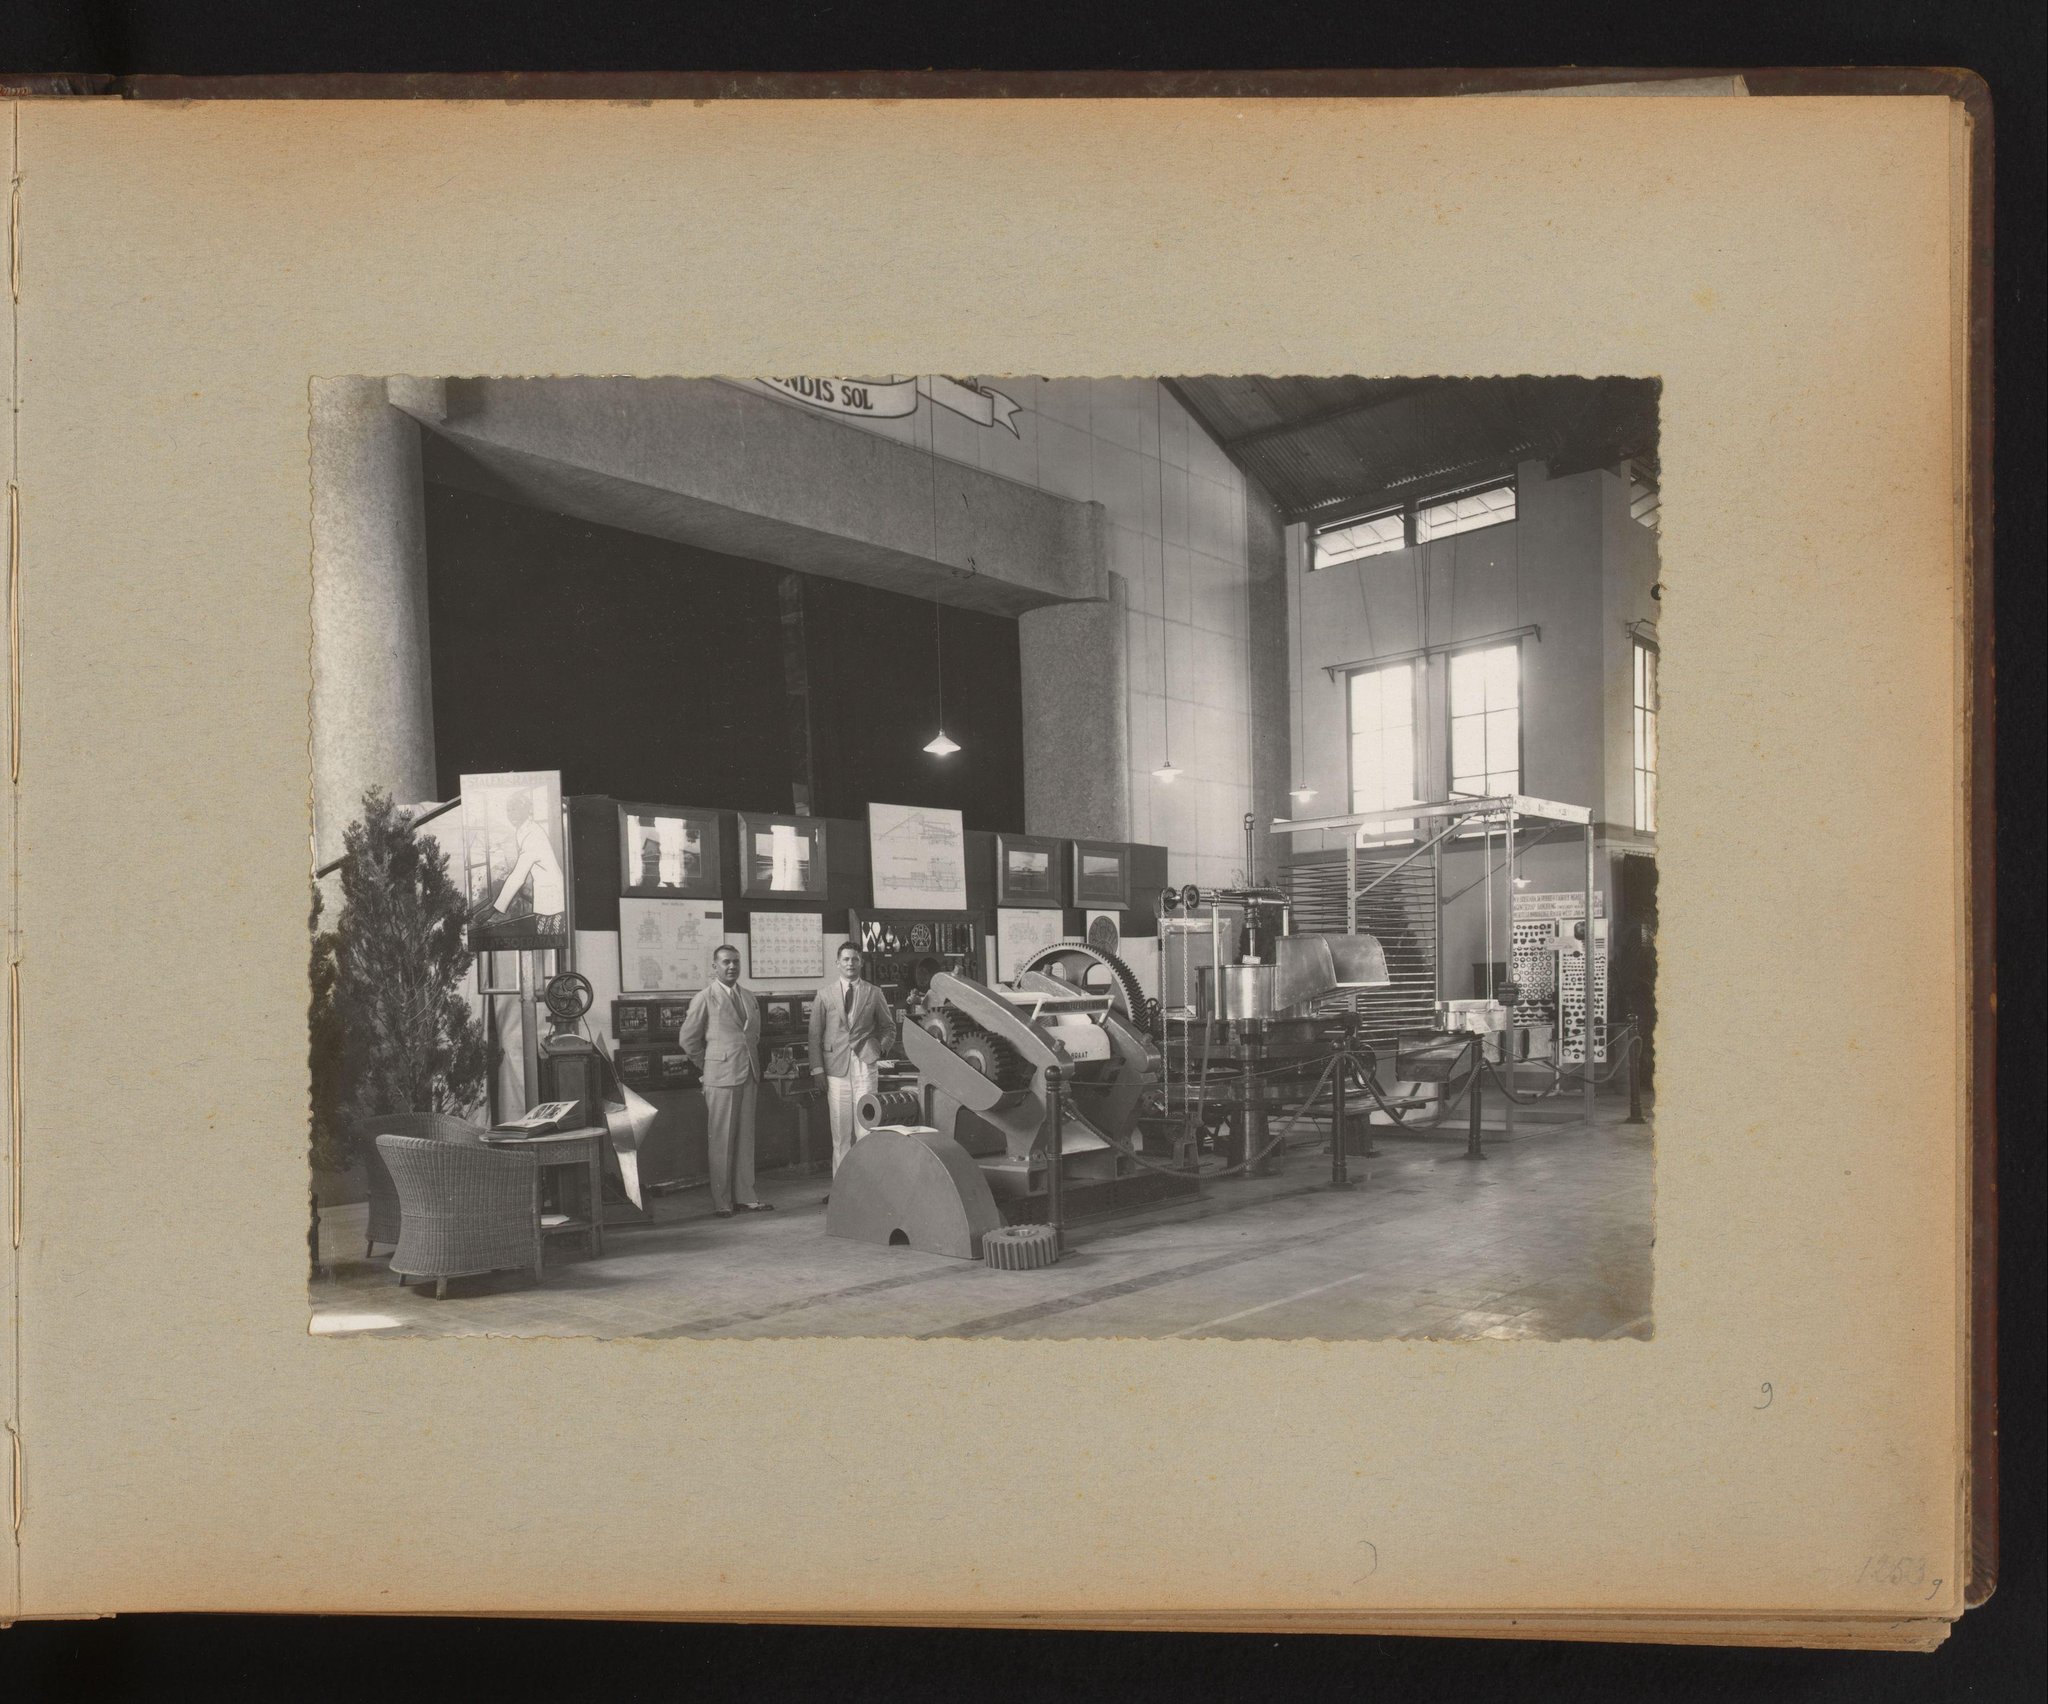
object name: photograph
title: Mannen poseren in de fabriek bij een uitstalling van machines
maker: Anonymous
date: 1931-1937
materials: cardboard, photographic support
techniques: gelatin silver print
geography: bandung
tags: factory-interior, machine shop, machines; parts of machines; tools and appliances, director, boss (in modern industry), java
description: Albumblad met een foto van twee Europese mannen poserend in de fabriek bij een uitstalling van machines, o.a. voor de theeindustrie. Aan een muur het stadswapen van Bandoeng met wapenspreuk "Ex Undis Sol". Onderdeel van een fotoalbum met foto's van machines en constructies van de N.V. Machinefabriek Braat te Soerabaja, Soekaboemi en Tegal uit de periode 1931-1937.